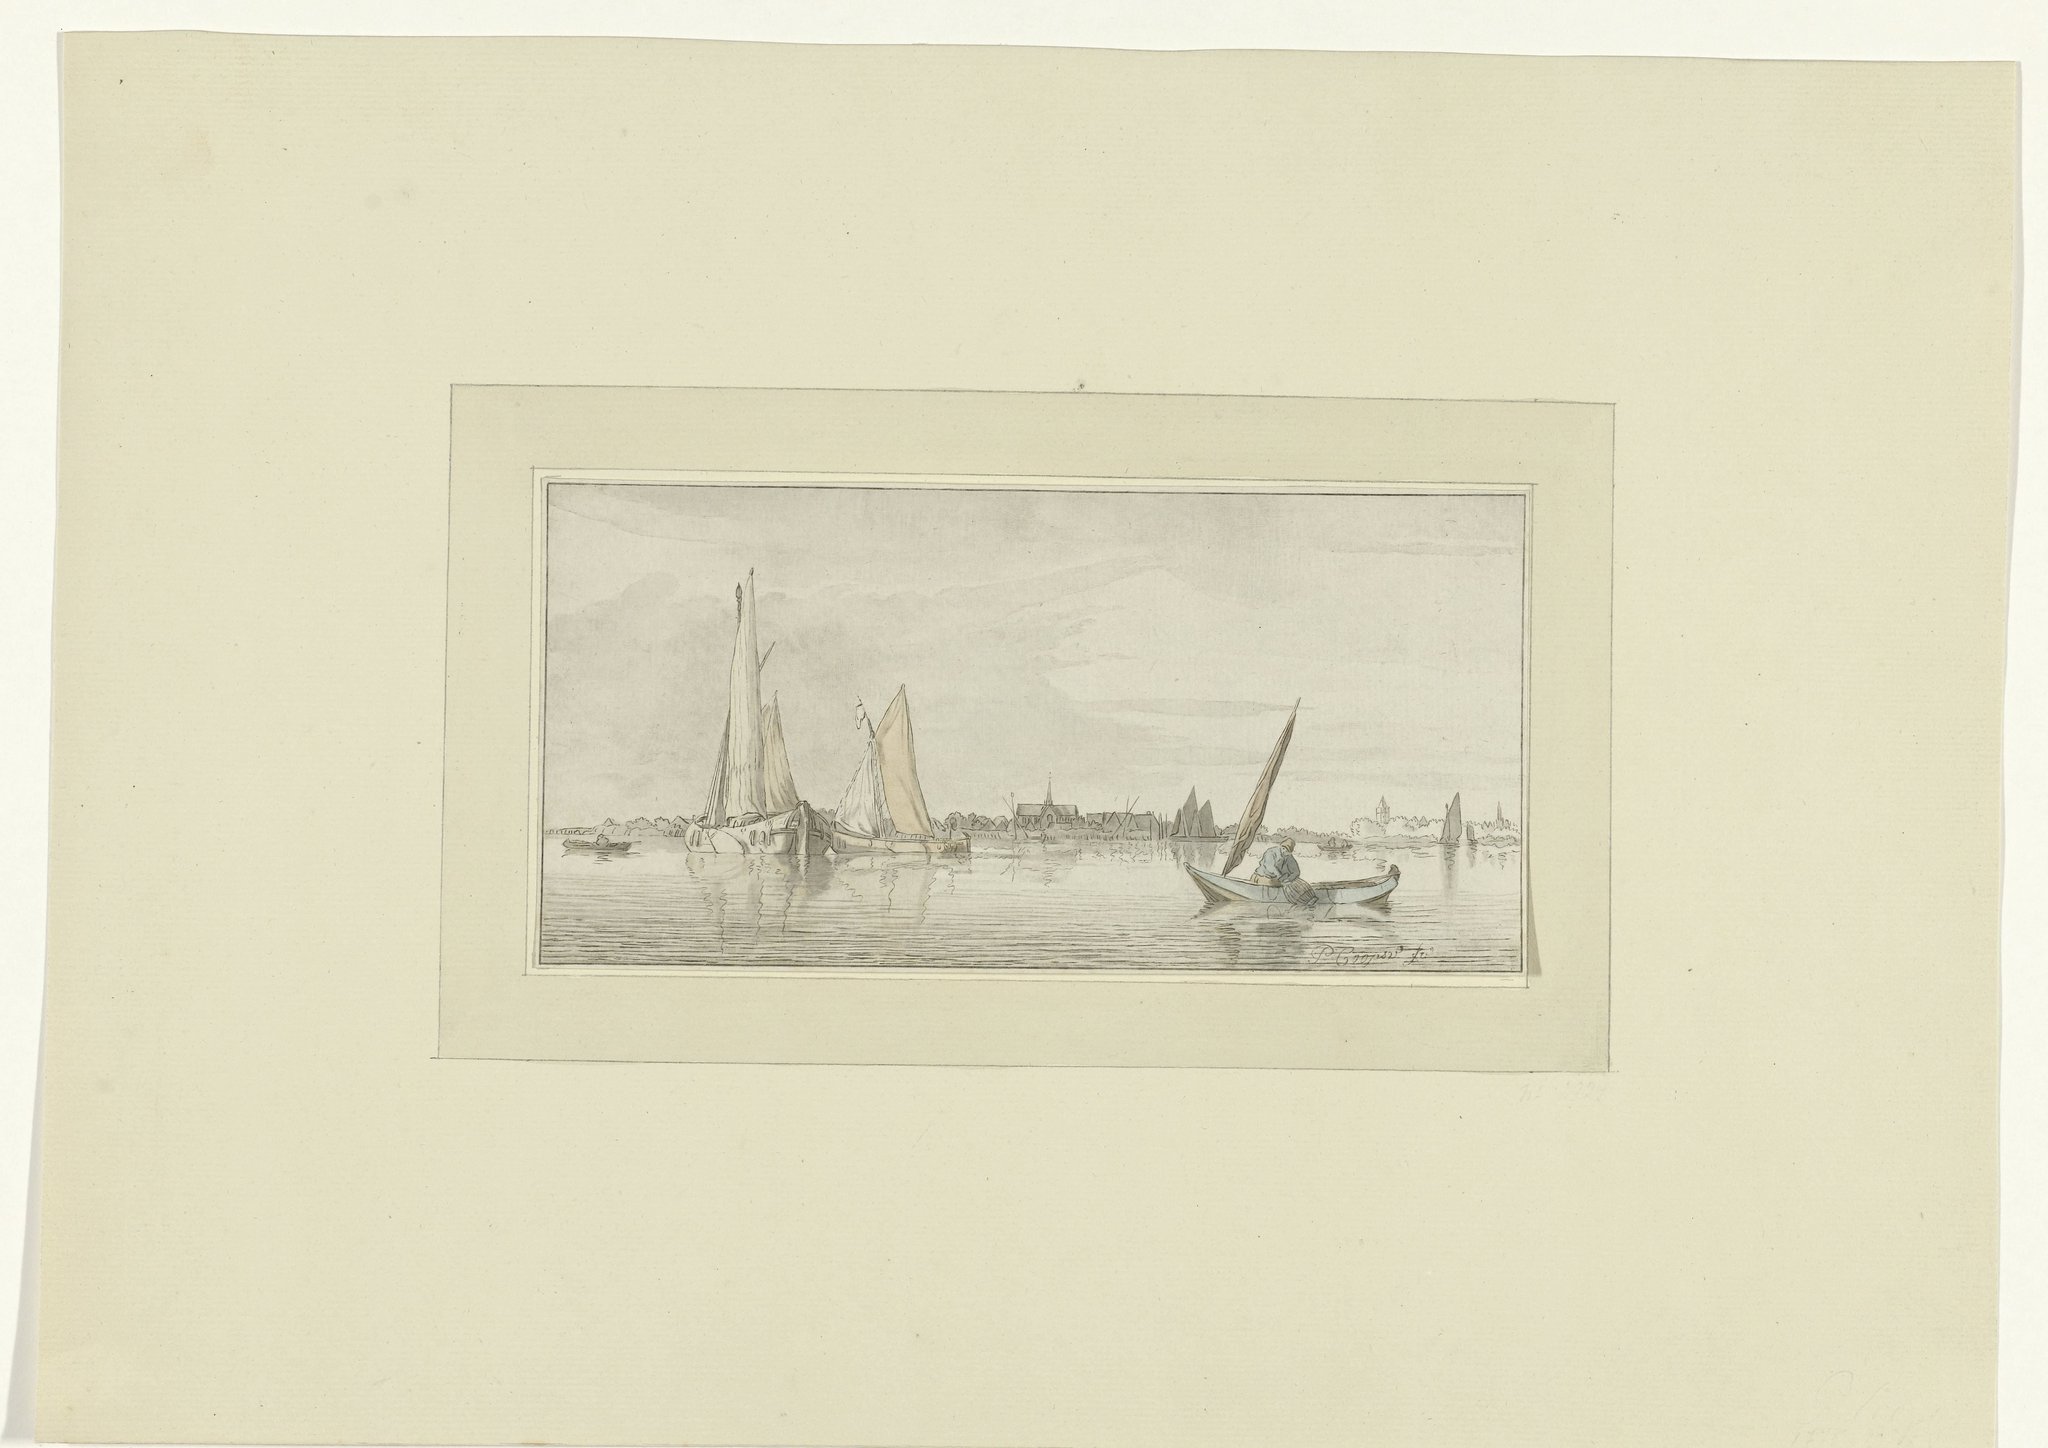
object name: print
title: Riviergezicht met een stad op de achtergrond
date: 1765-1772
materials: paper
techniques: color aquatint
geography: amsterdam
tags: sailing-ship, sailing-boat, river, church (exterior), fisherman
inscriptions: collector's mark: Lugt 2228, collector's mark: Lugt 2725, collector's mark: Lugt 2760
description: Gezicht op een rivier met op de voorgrond enkele boten, waarvan er in één een visser zit. Op de achtergrond zijn de contouren van een stad en de stadskerk zichtbaar.